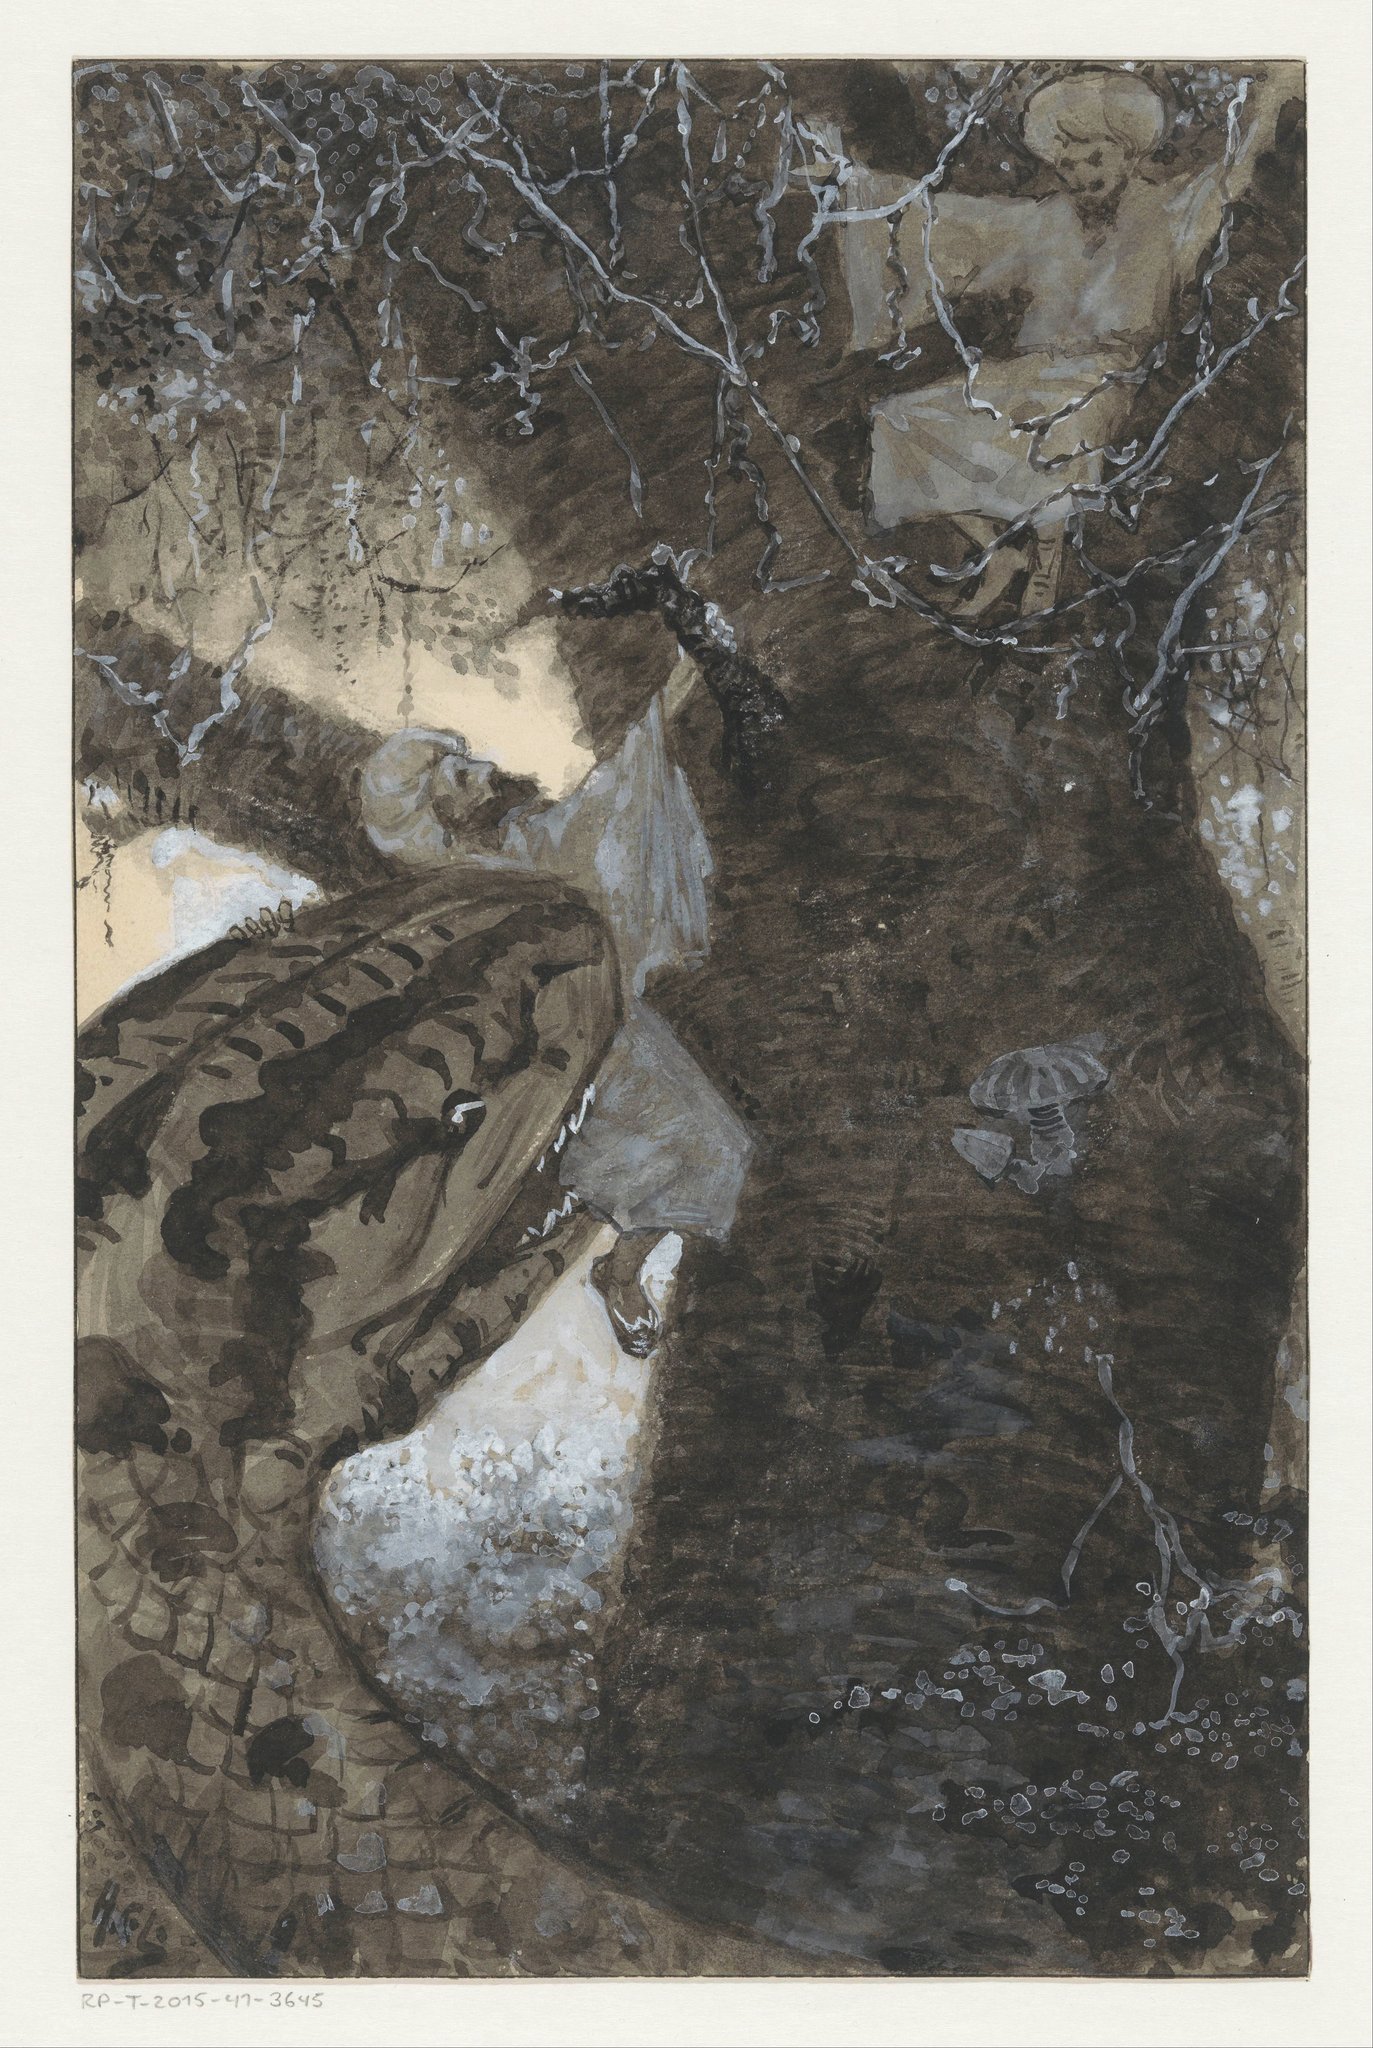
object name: boekillustratie ontwerp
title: Man in boom wordt door een slang gegrepen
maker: h.c. louwerse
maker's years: 1878-1946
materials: paint, paper, pencil, watercolor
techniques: brush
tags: snakes, trees, head-gear: turban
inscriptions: signature: ‘H.C.L.’, number: ‘No 1303’, collector's mark: Lugt 2228a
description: Twee bebaarde mannen in lange tunieken en met tulbanden op het hoofd zijn in een boom geklommen. De man die het minst hoog is geklommen wordt gegrepen door een reusachtige slang.